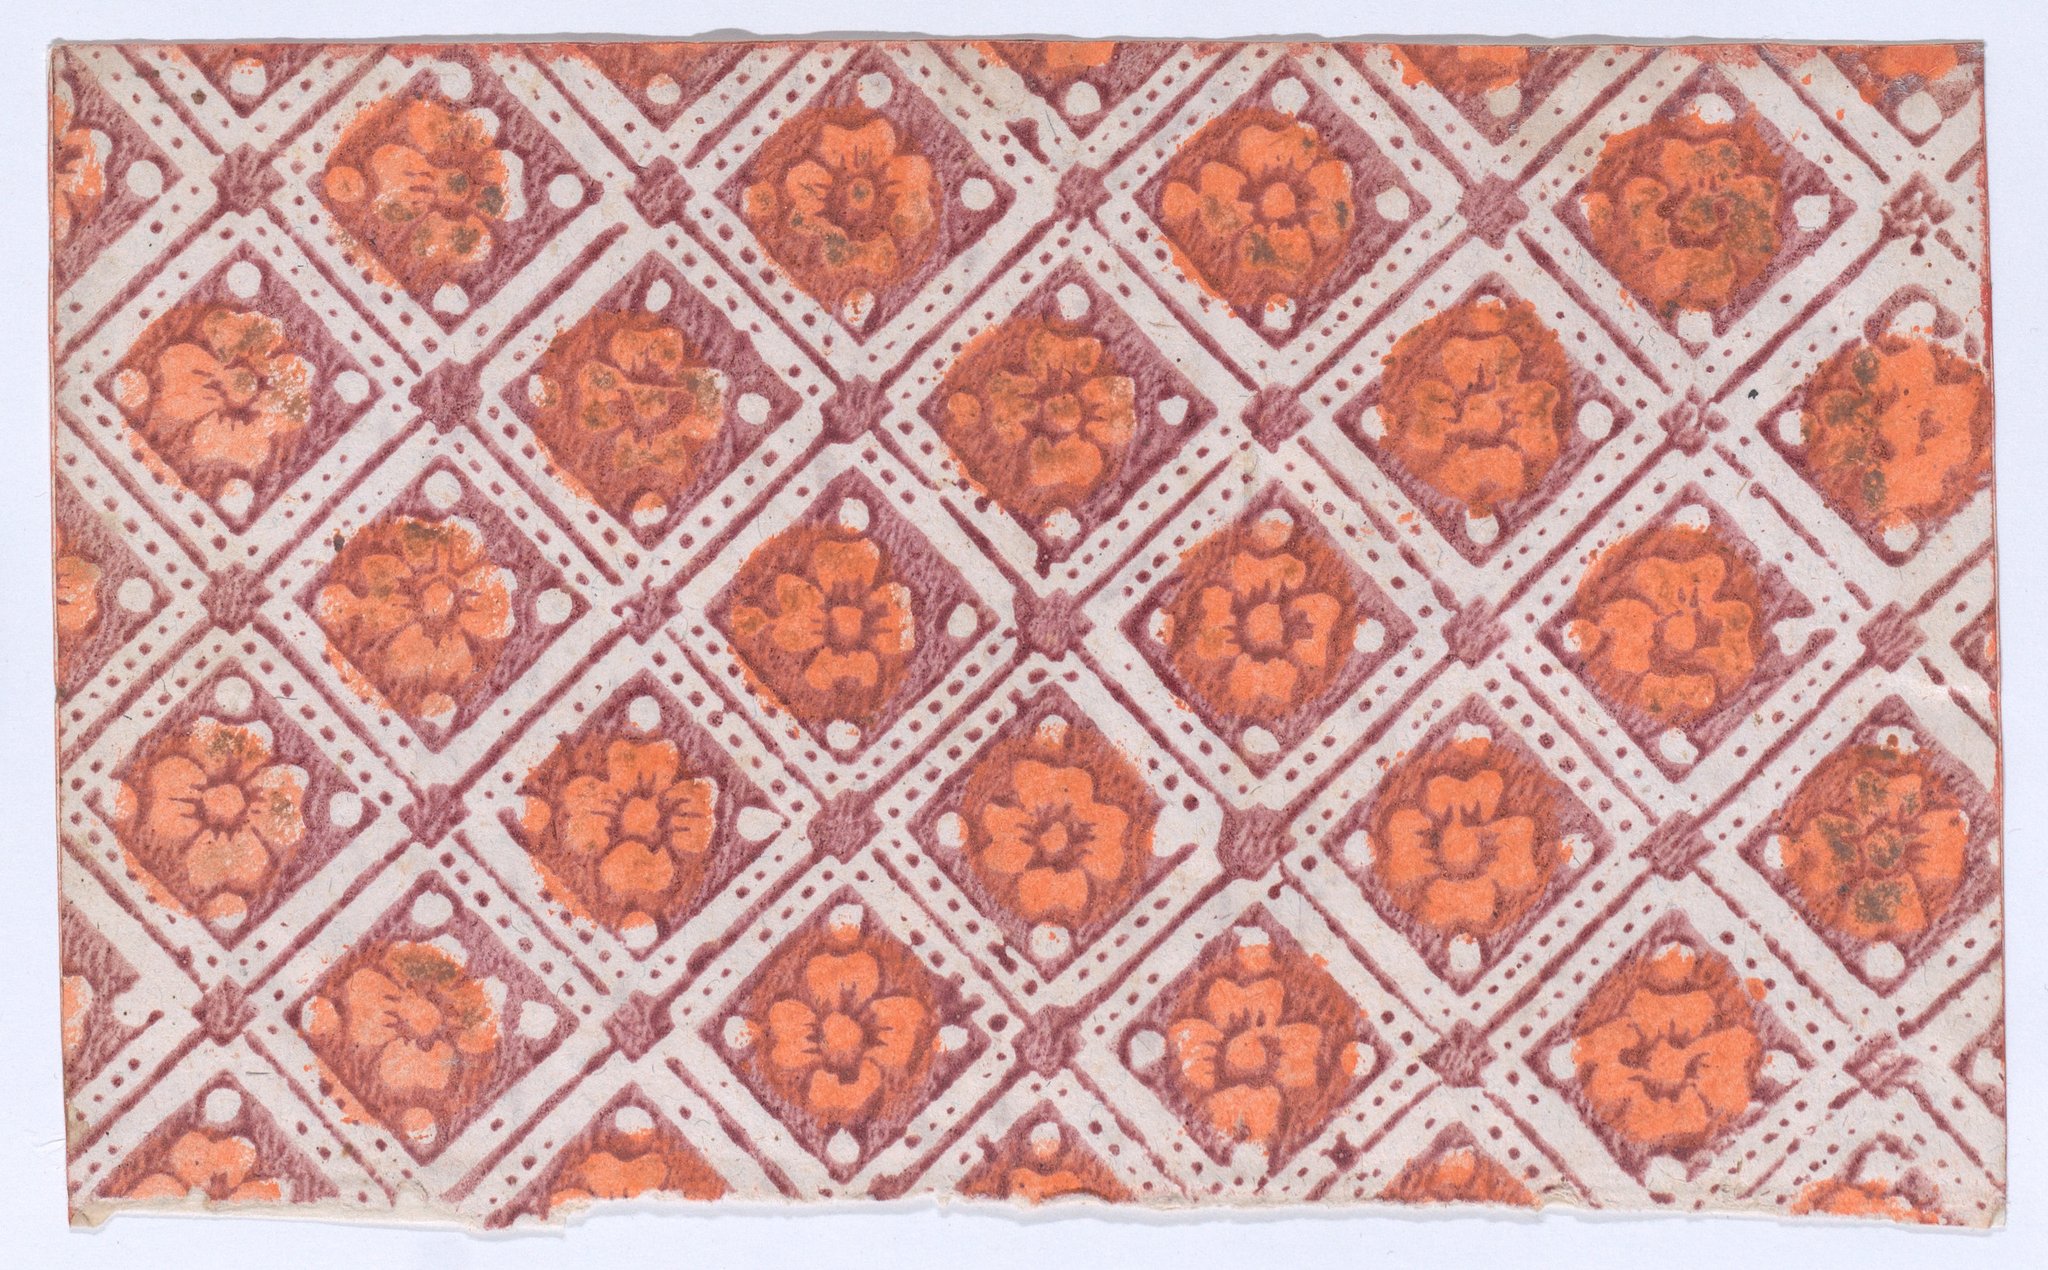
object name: print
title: Sheet with overall pattern of rosettes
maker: Anonymous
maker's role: artist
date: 1801-1900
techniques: relief print